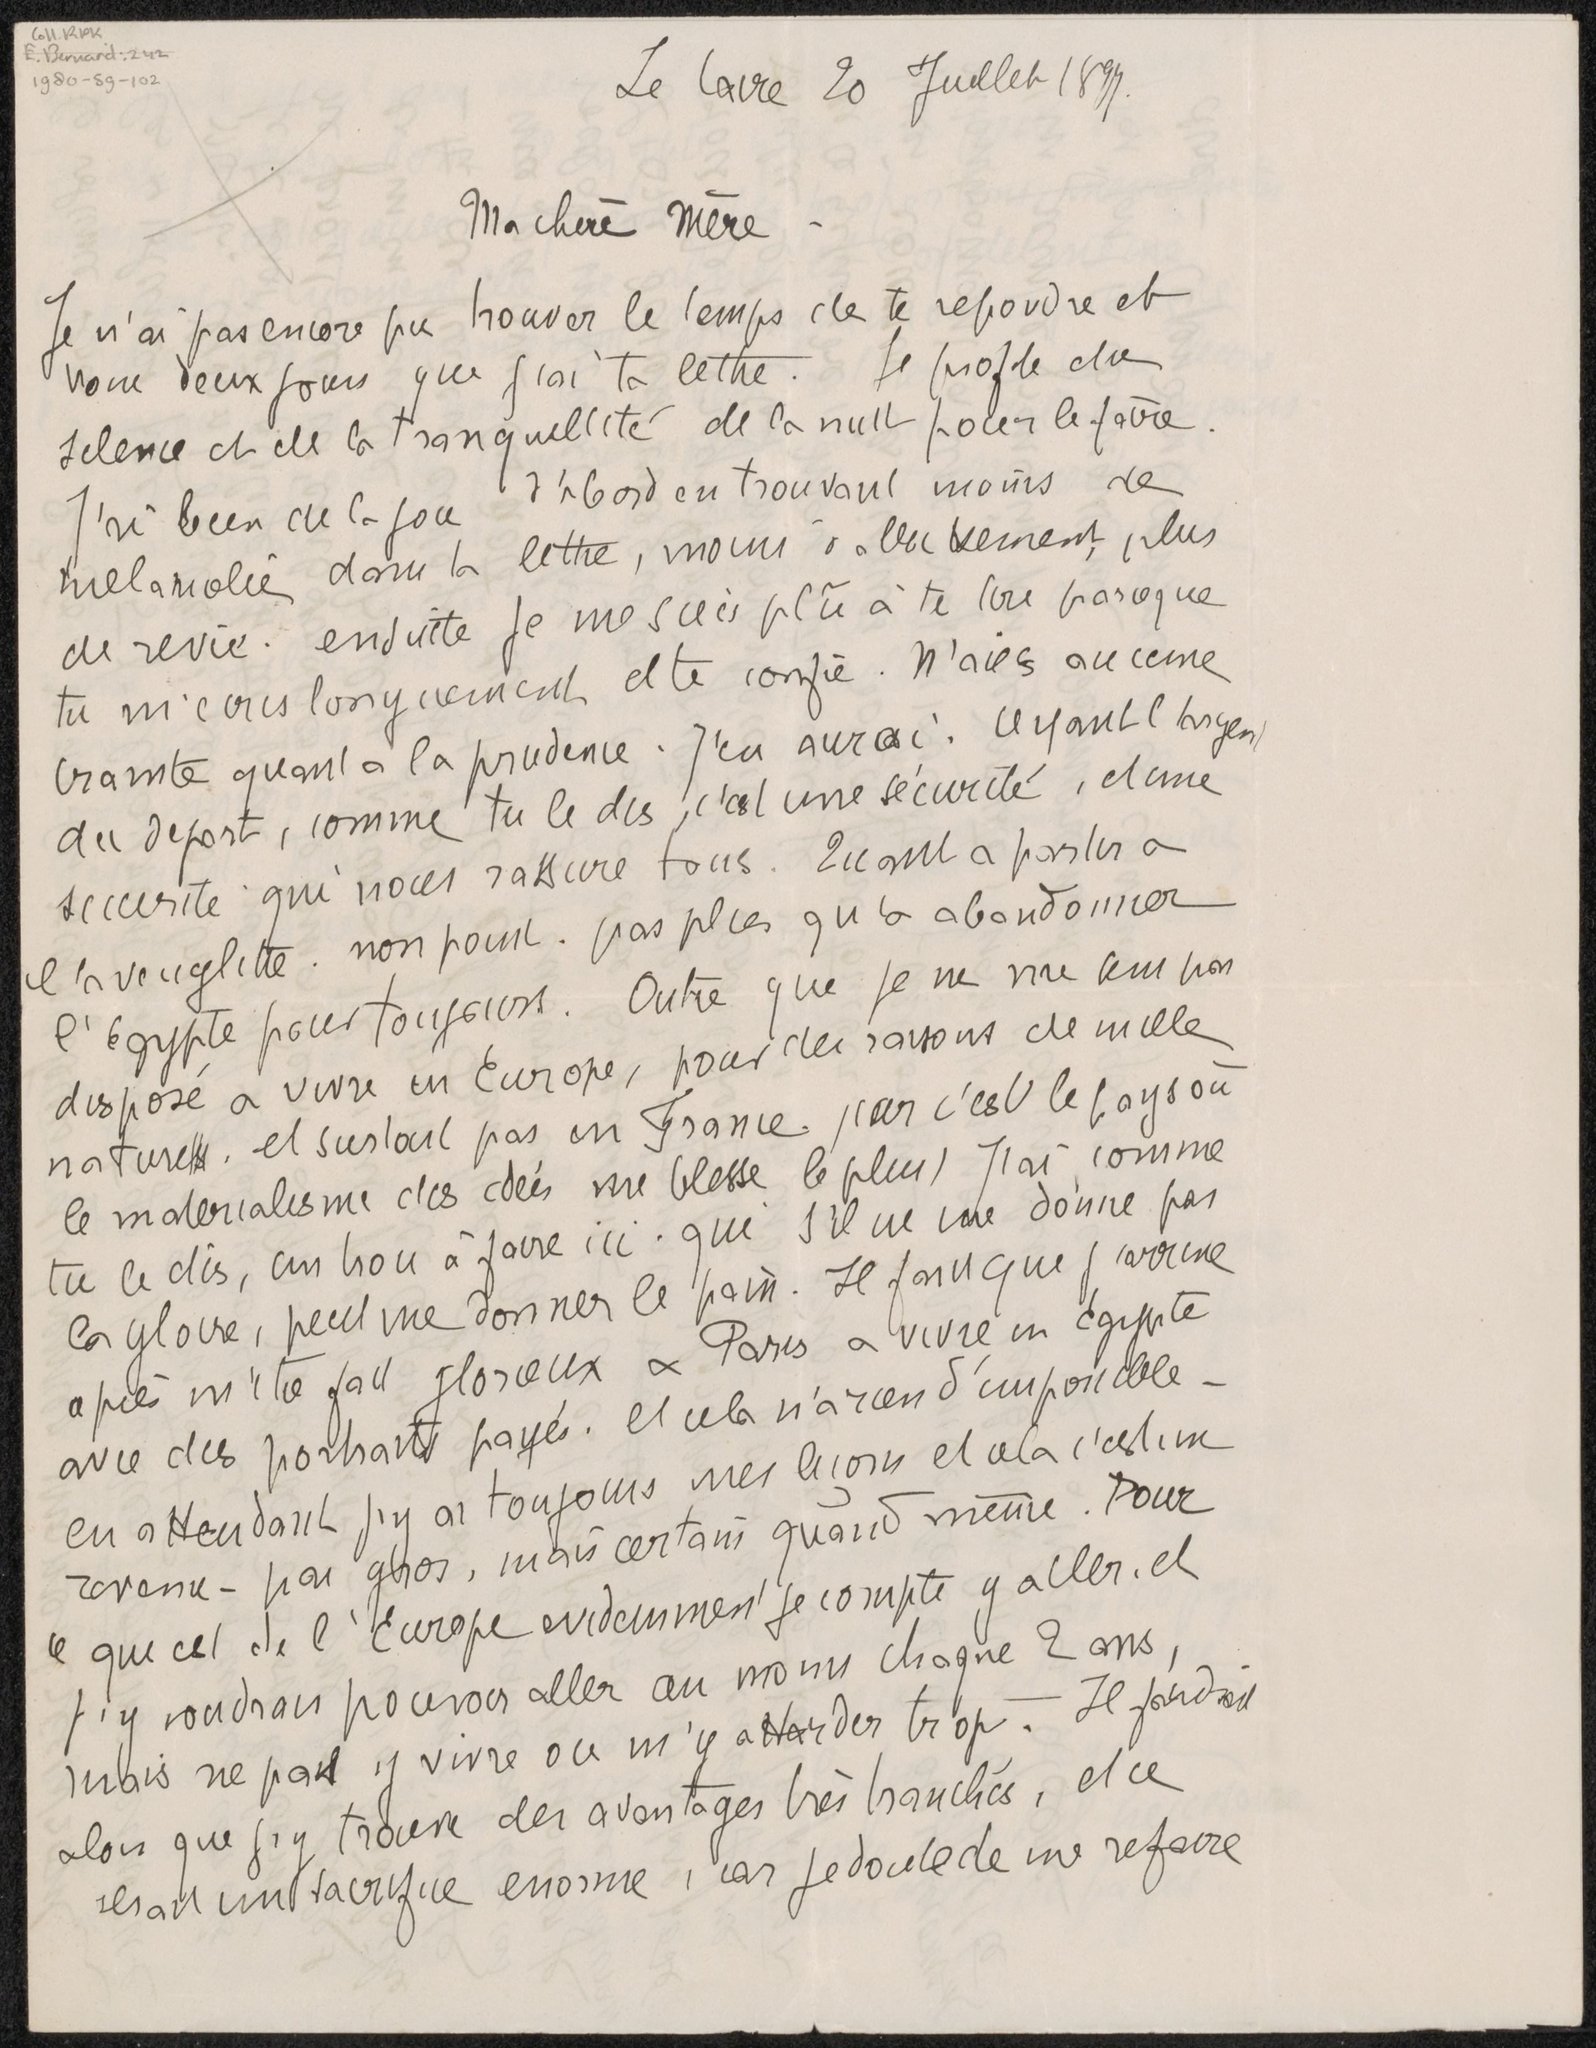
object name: letter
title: Brief aan Héloïse Bernard-Bodin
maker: émile bernard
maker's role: print maker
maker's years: 1868-1941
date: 1899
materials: ink, paper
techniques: pen, writing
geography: cairo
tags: héloïse bernard-bodin